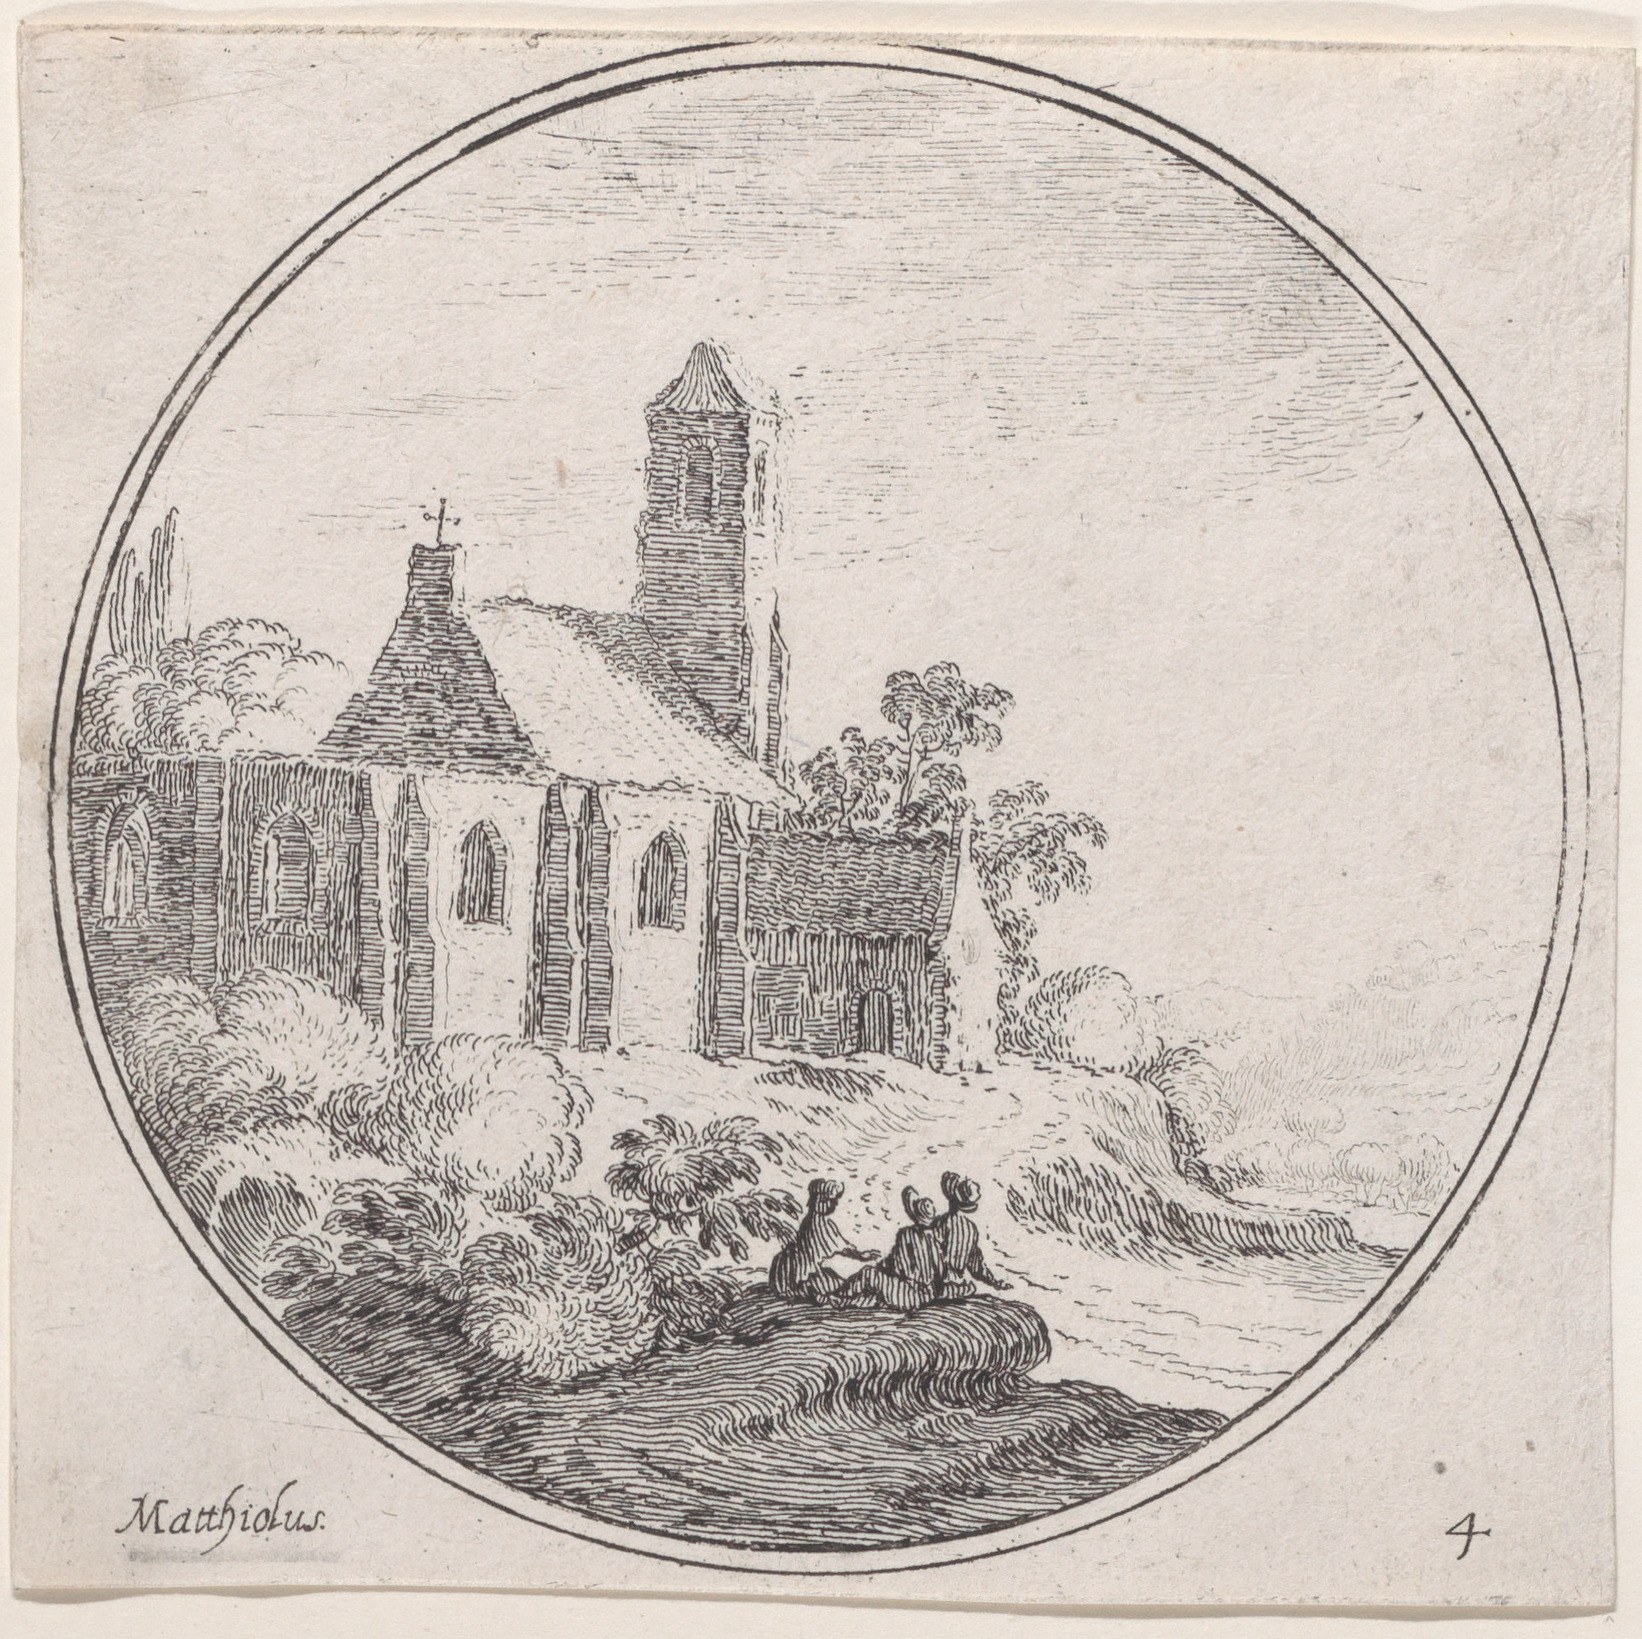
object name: print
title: Plate 4: three figures seated outside of a church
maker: lodovico mattioli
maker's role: artist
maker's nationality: italian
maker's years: 1662-1747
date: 1680-1747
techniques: etching